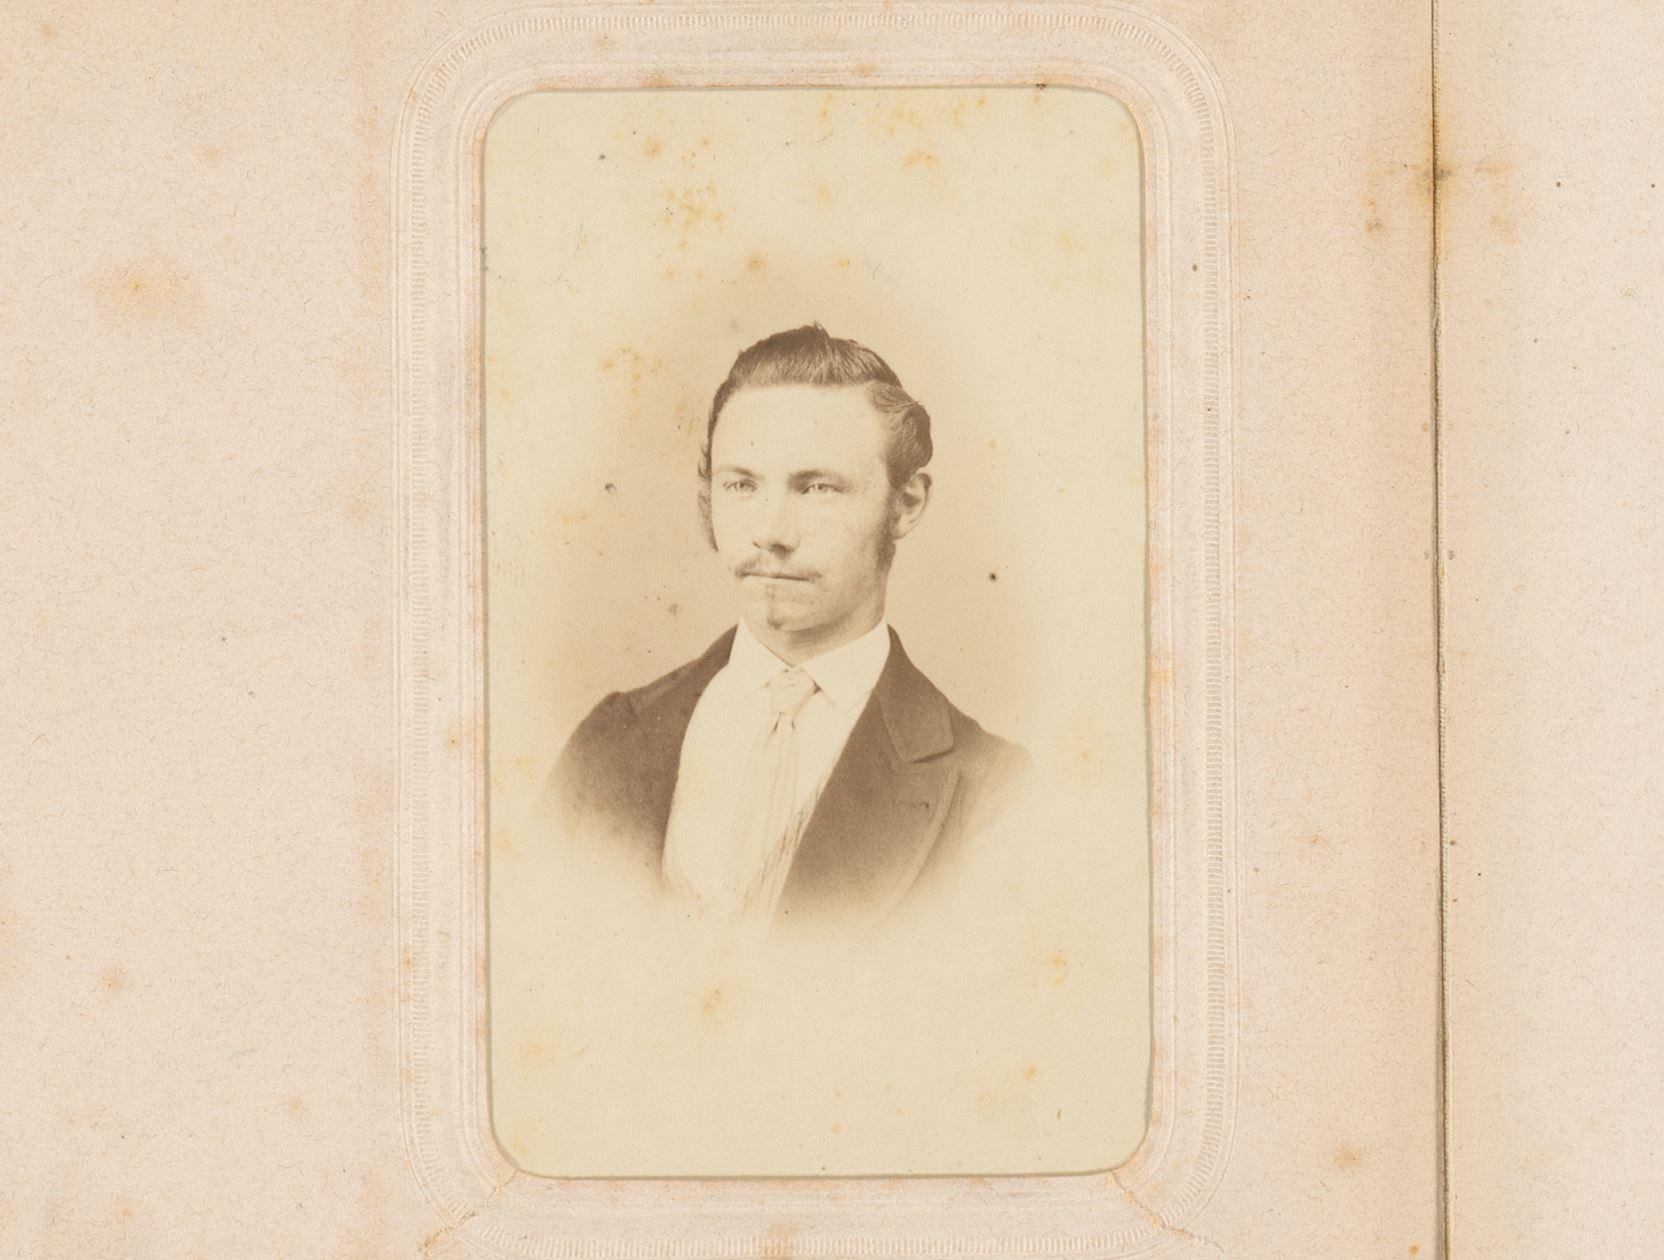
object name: carte de visite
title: Portret van een man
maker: auguste osbert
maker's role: fotograaf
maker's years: 1850-1879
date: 1860-1900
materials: cardboard, photographic support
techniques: albumen print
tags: adult man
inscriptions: inscription: ‘Osbert/ 67 Rue de Rivoli/ Paris’